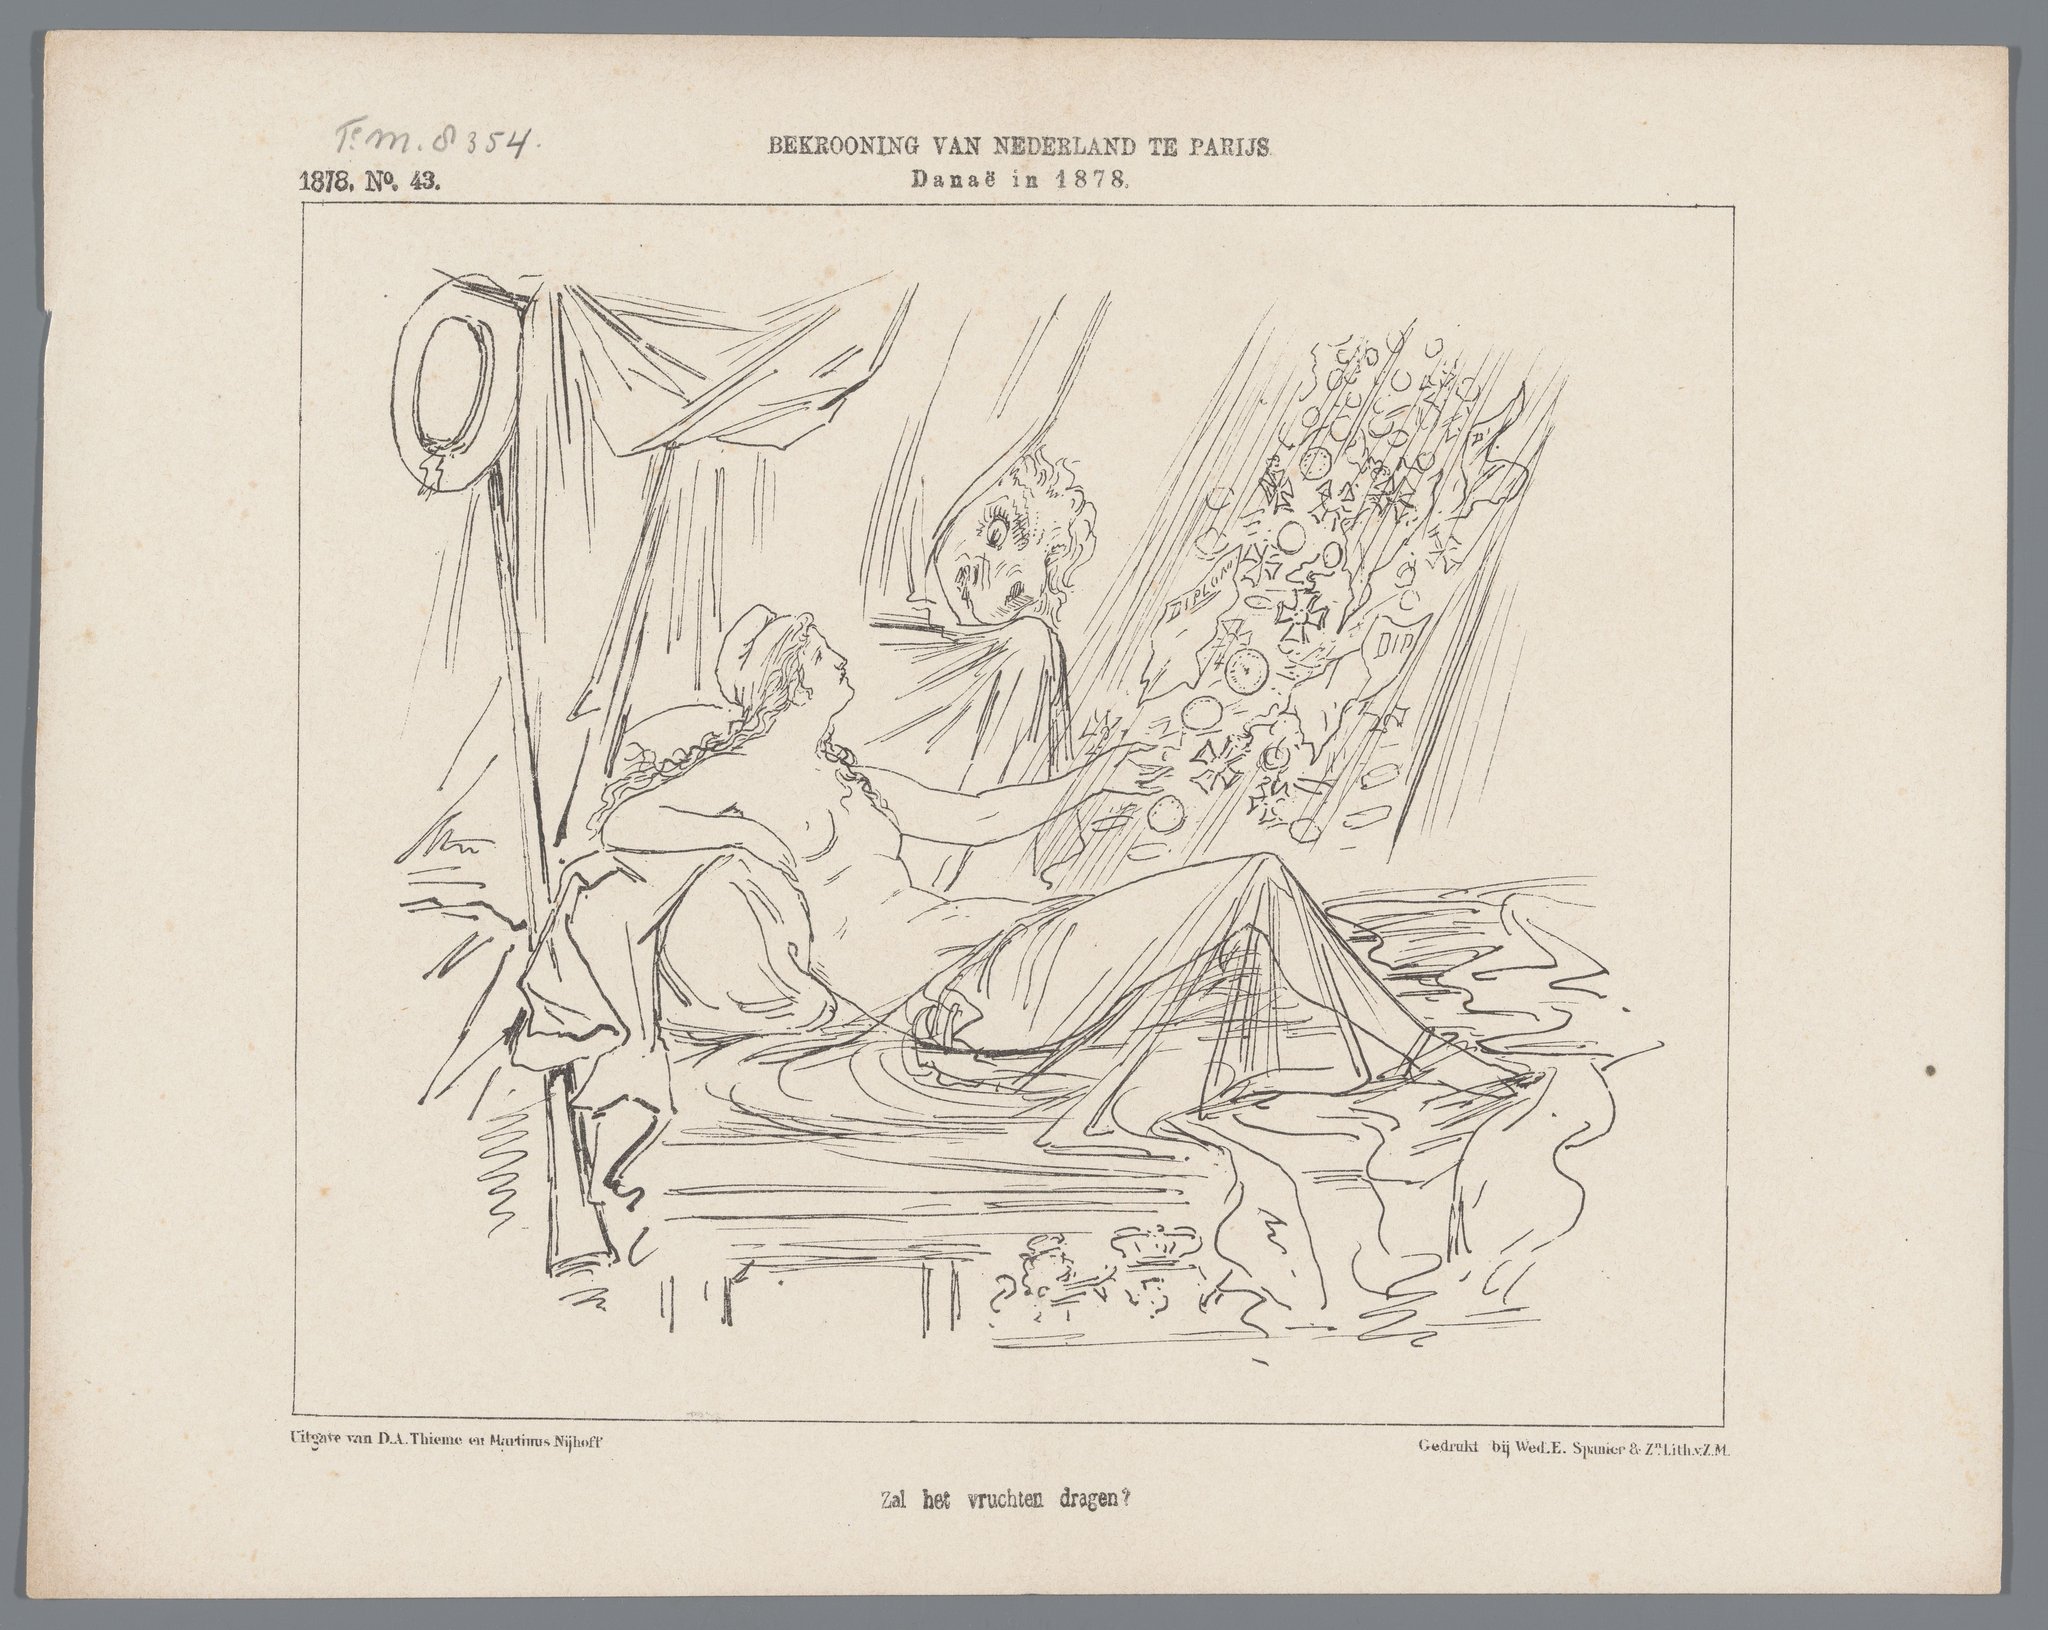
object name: cartoon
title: Bekrooning van Nederland te Parijs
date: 1878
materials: paper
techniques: lithograph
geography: the hague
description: Spotprent. Plaat verschenen bij het weekblad De Nederlandsche Spectator, nr. 43, 1878.